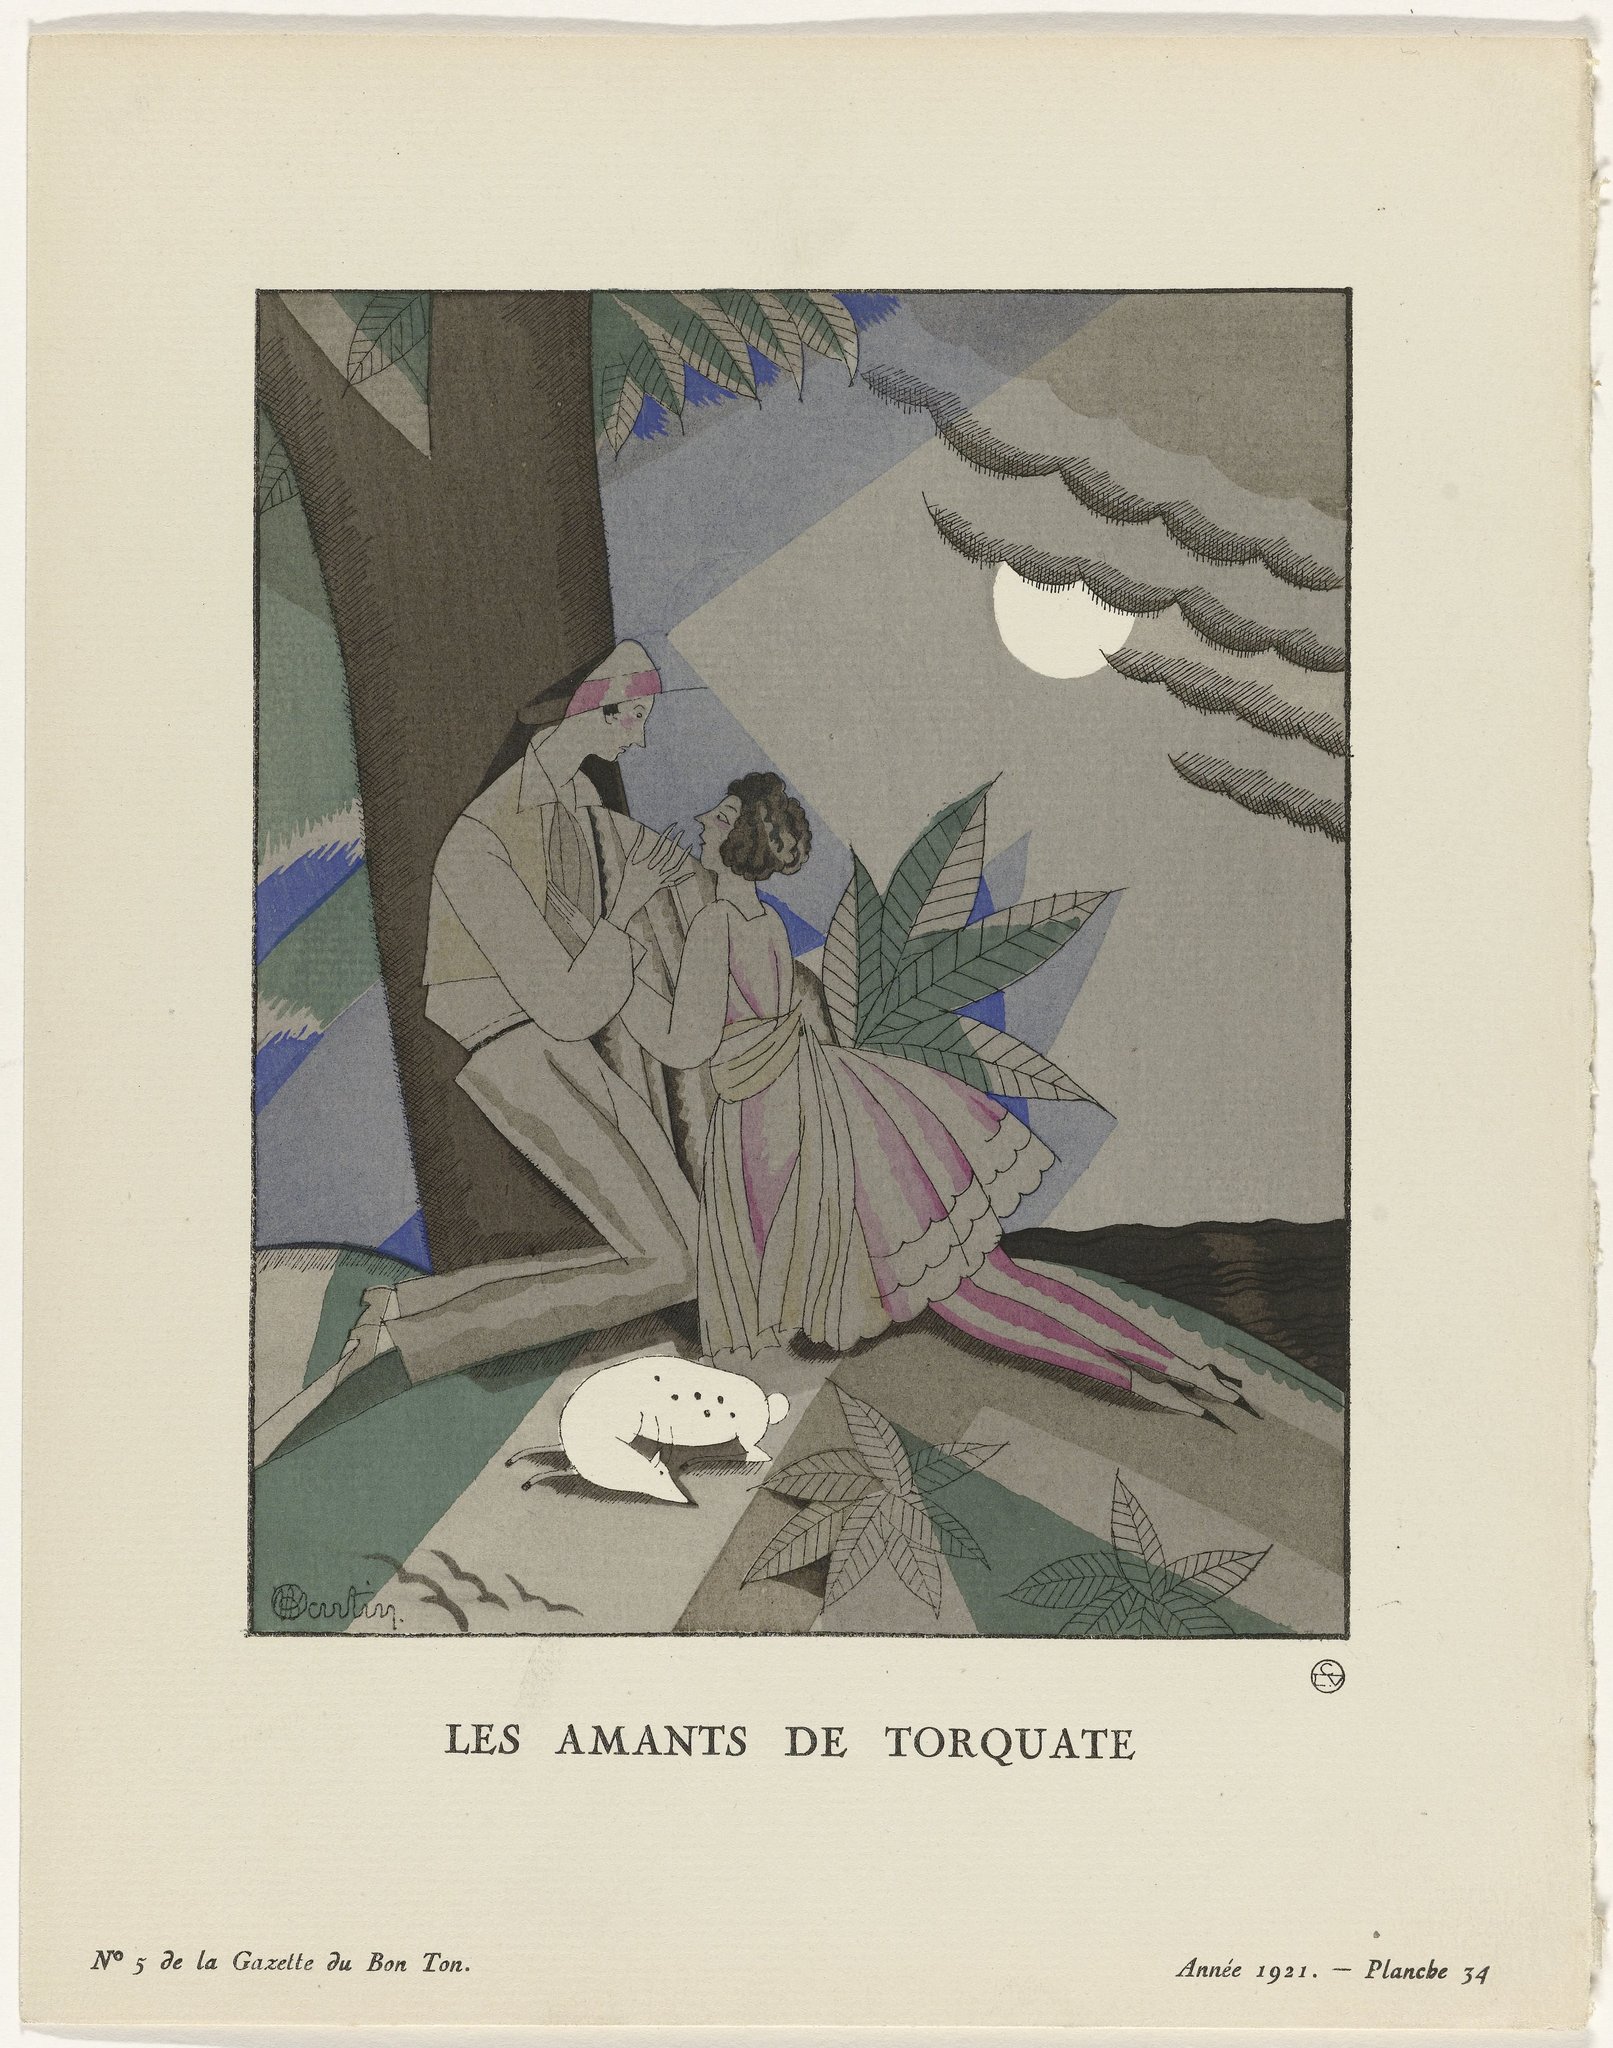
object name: fashion print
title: Gazette du Bon Ton, 1921 - No. 5, Pl. 34: Les amants de torquate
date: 1921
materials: paper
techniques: hand coloring, letterpress printing, lithograph, pochoir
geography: new york city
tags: animals, ensembles of pieces of clothing (suit) (+ men's clothes), fashion plates, dress, gown (+ women's clothes), couple of lovers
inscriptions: date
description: Twee geliefden onder een boom bij het water. De vrouw draagt een japon met geschulpte zoom en om het middel een ceintuur. Planche 34 uit Gazette du Bon Ton 1921, No. 5. Uitleg over de kleding op pagina "Explication des Planches Hors-Texte. Contenues dans ce numéro."